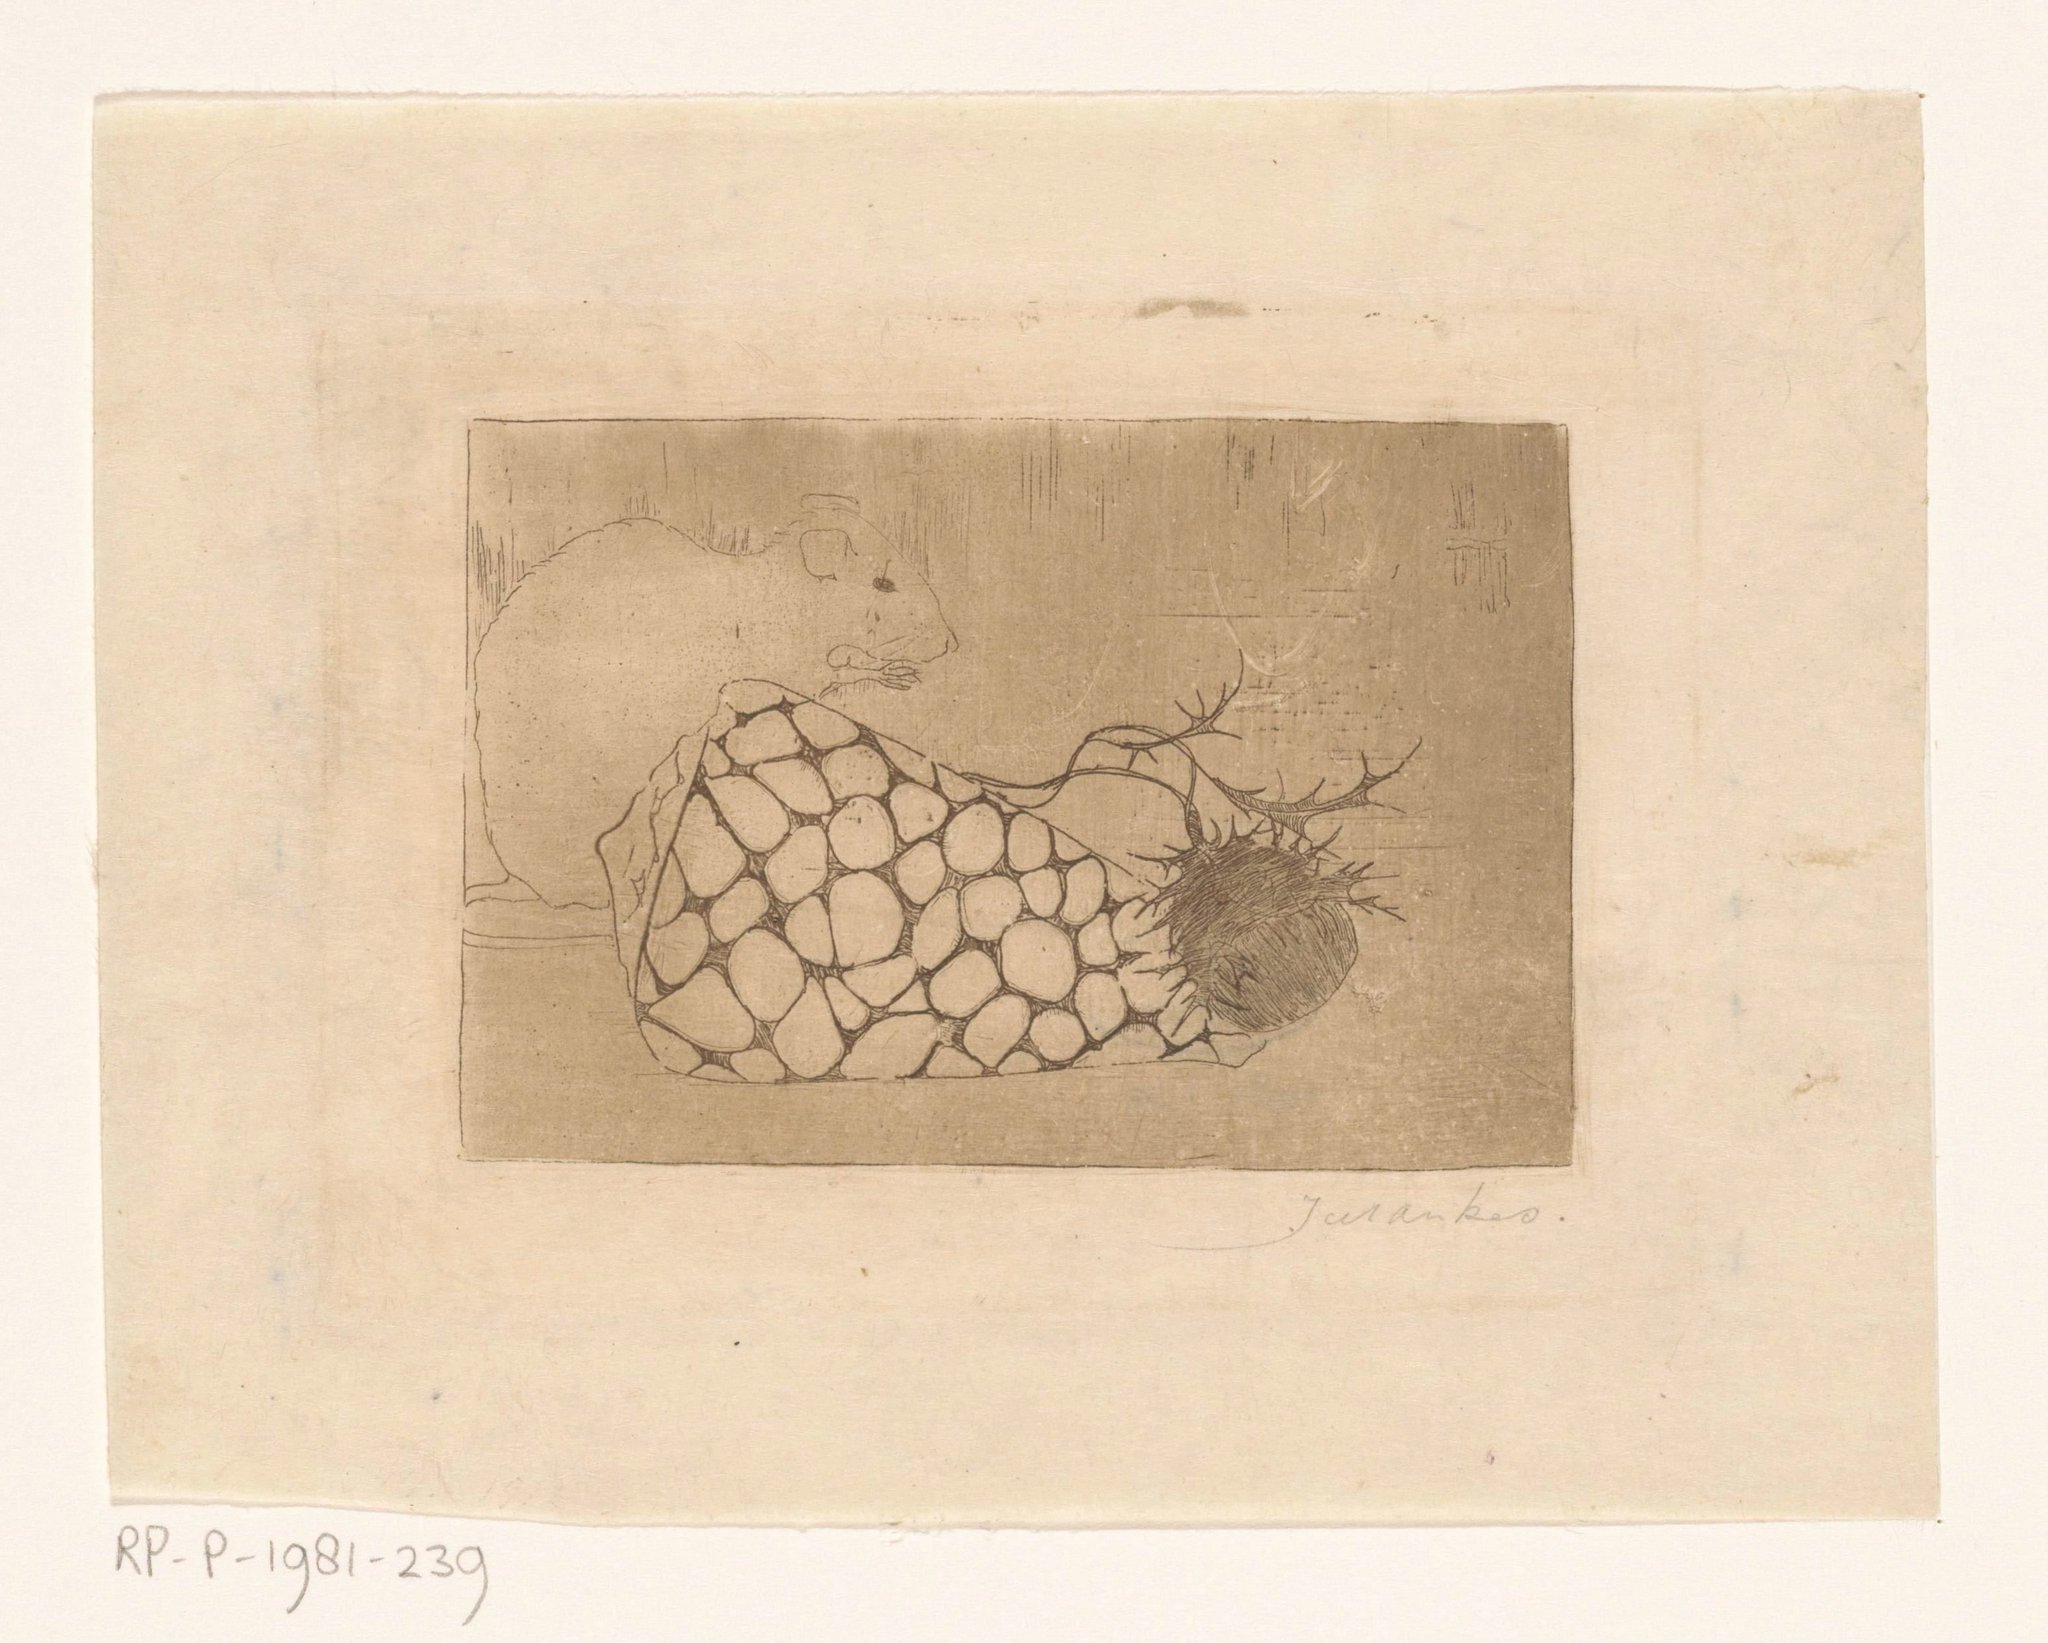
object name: print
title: Muis, schelp en distel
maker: jan mankes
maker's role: draughtsman, painter, print maker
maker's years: 1889-1920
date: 1910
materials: paper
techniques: etching, intaglio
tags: rodents: mouse, molluscs (+ shell, snail-shell etc.), plants and herbs: thistle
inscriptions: collector's mark: Lugt 2228